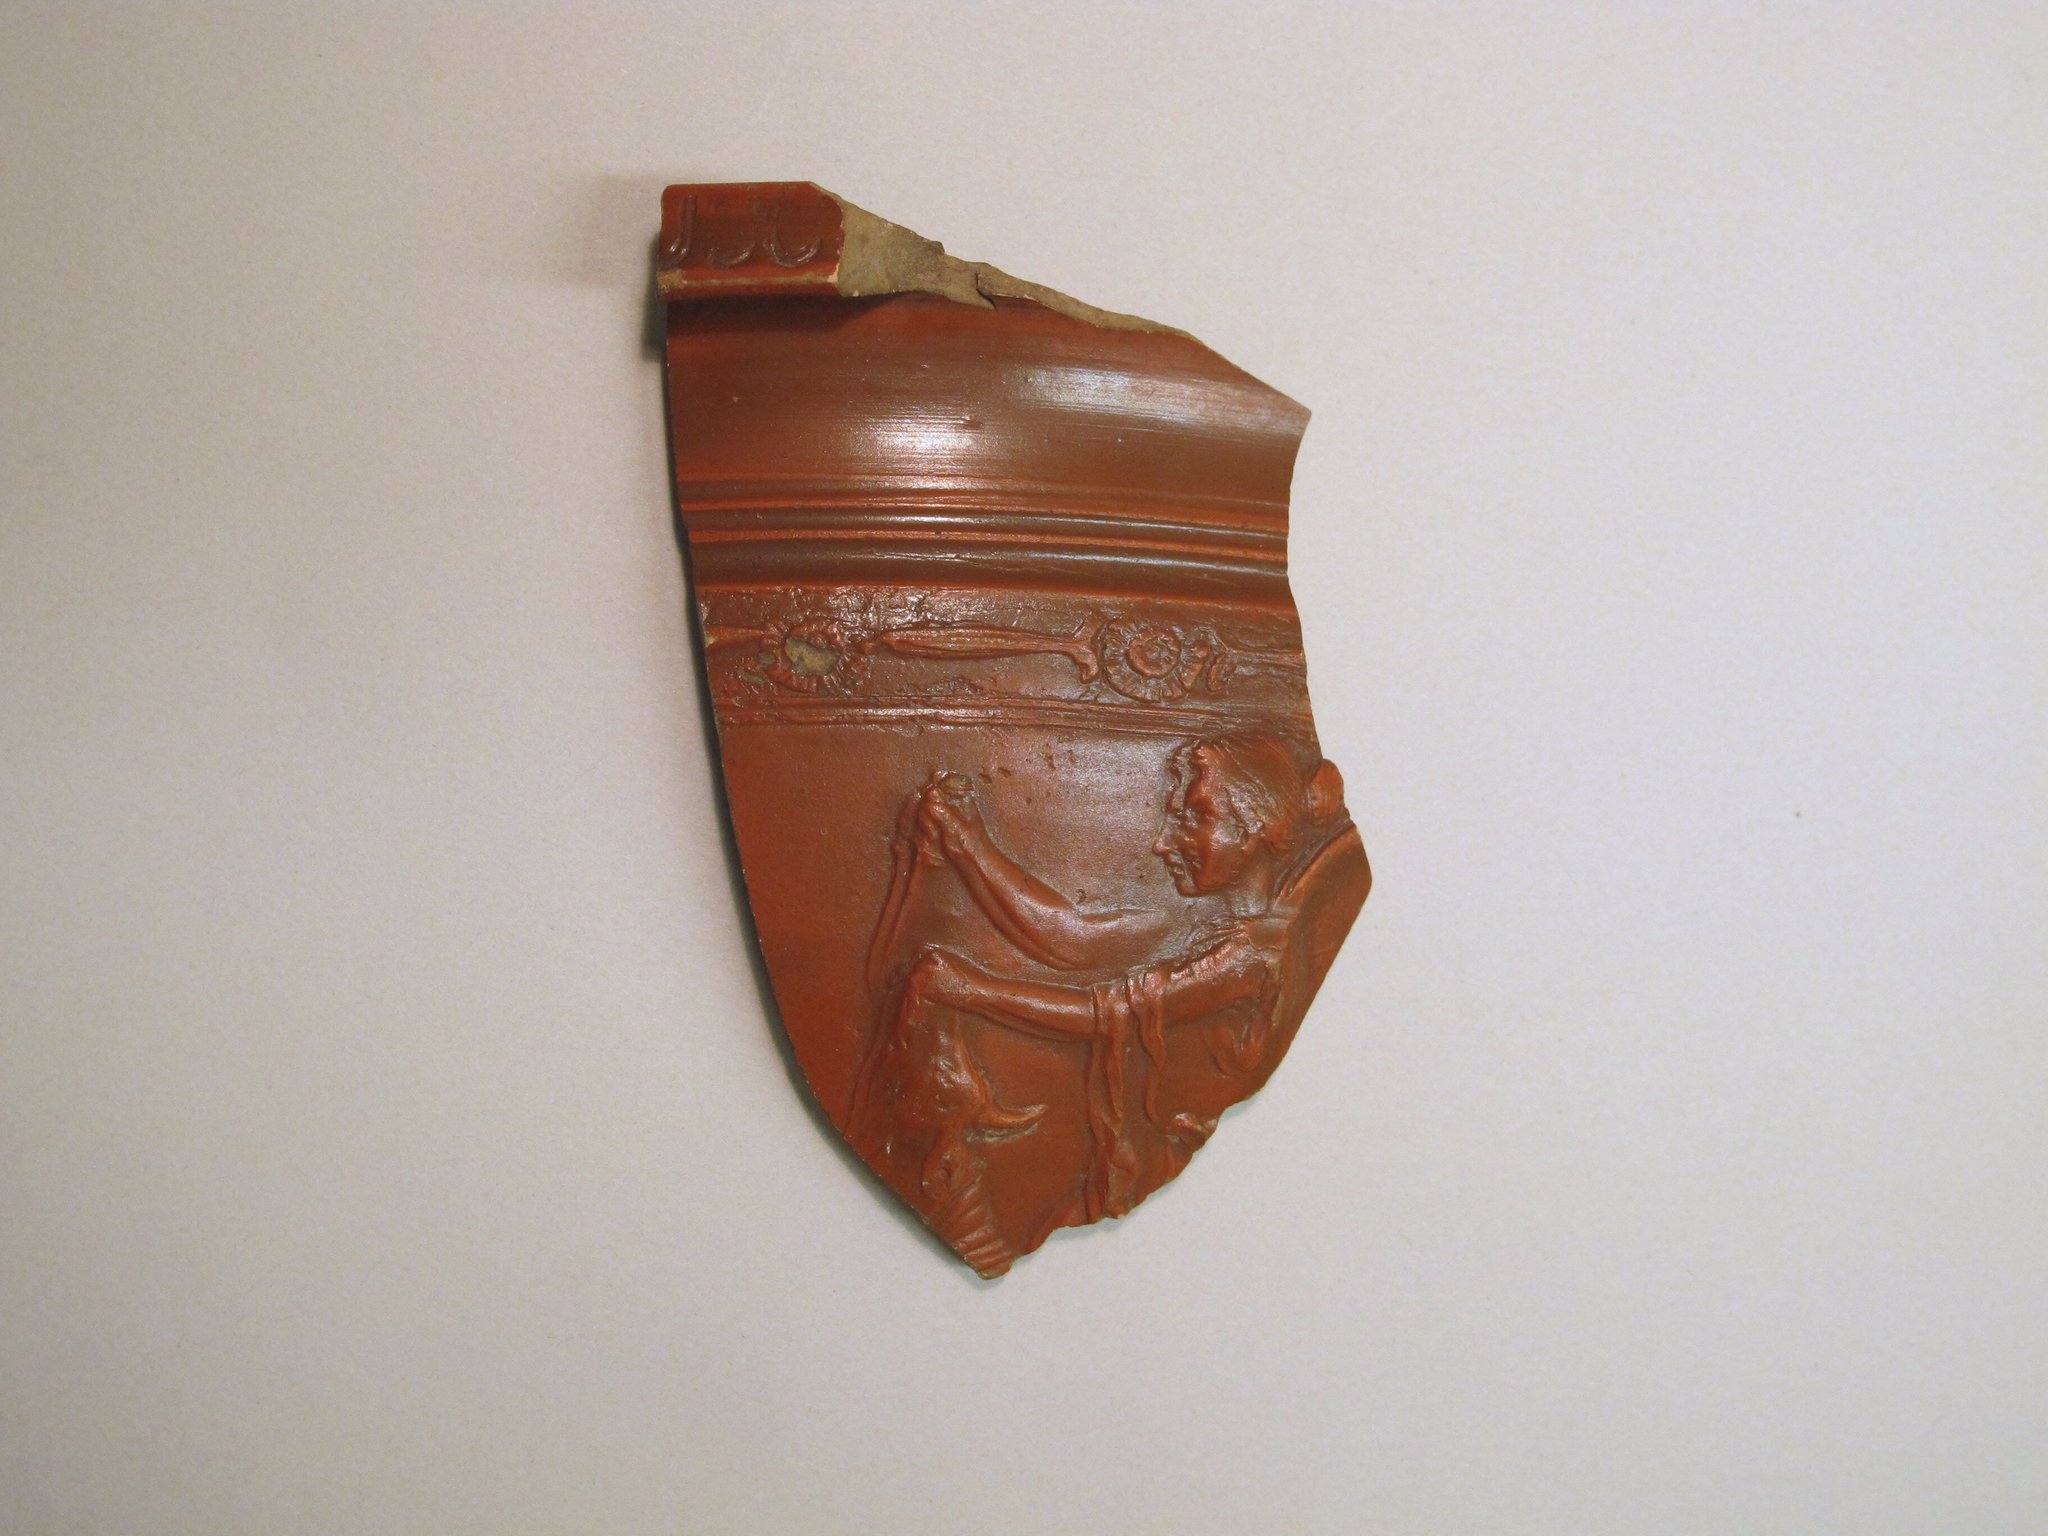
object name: vase fragment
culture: roman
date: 100 BCE-100 CE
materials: terracotta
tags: nike